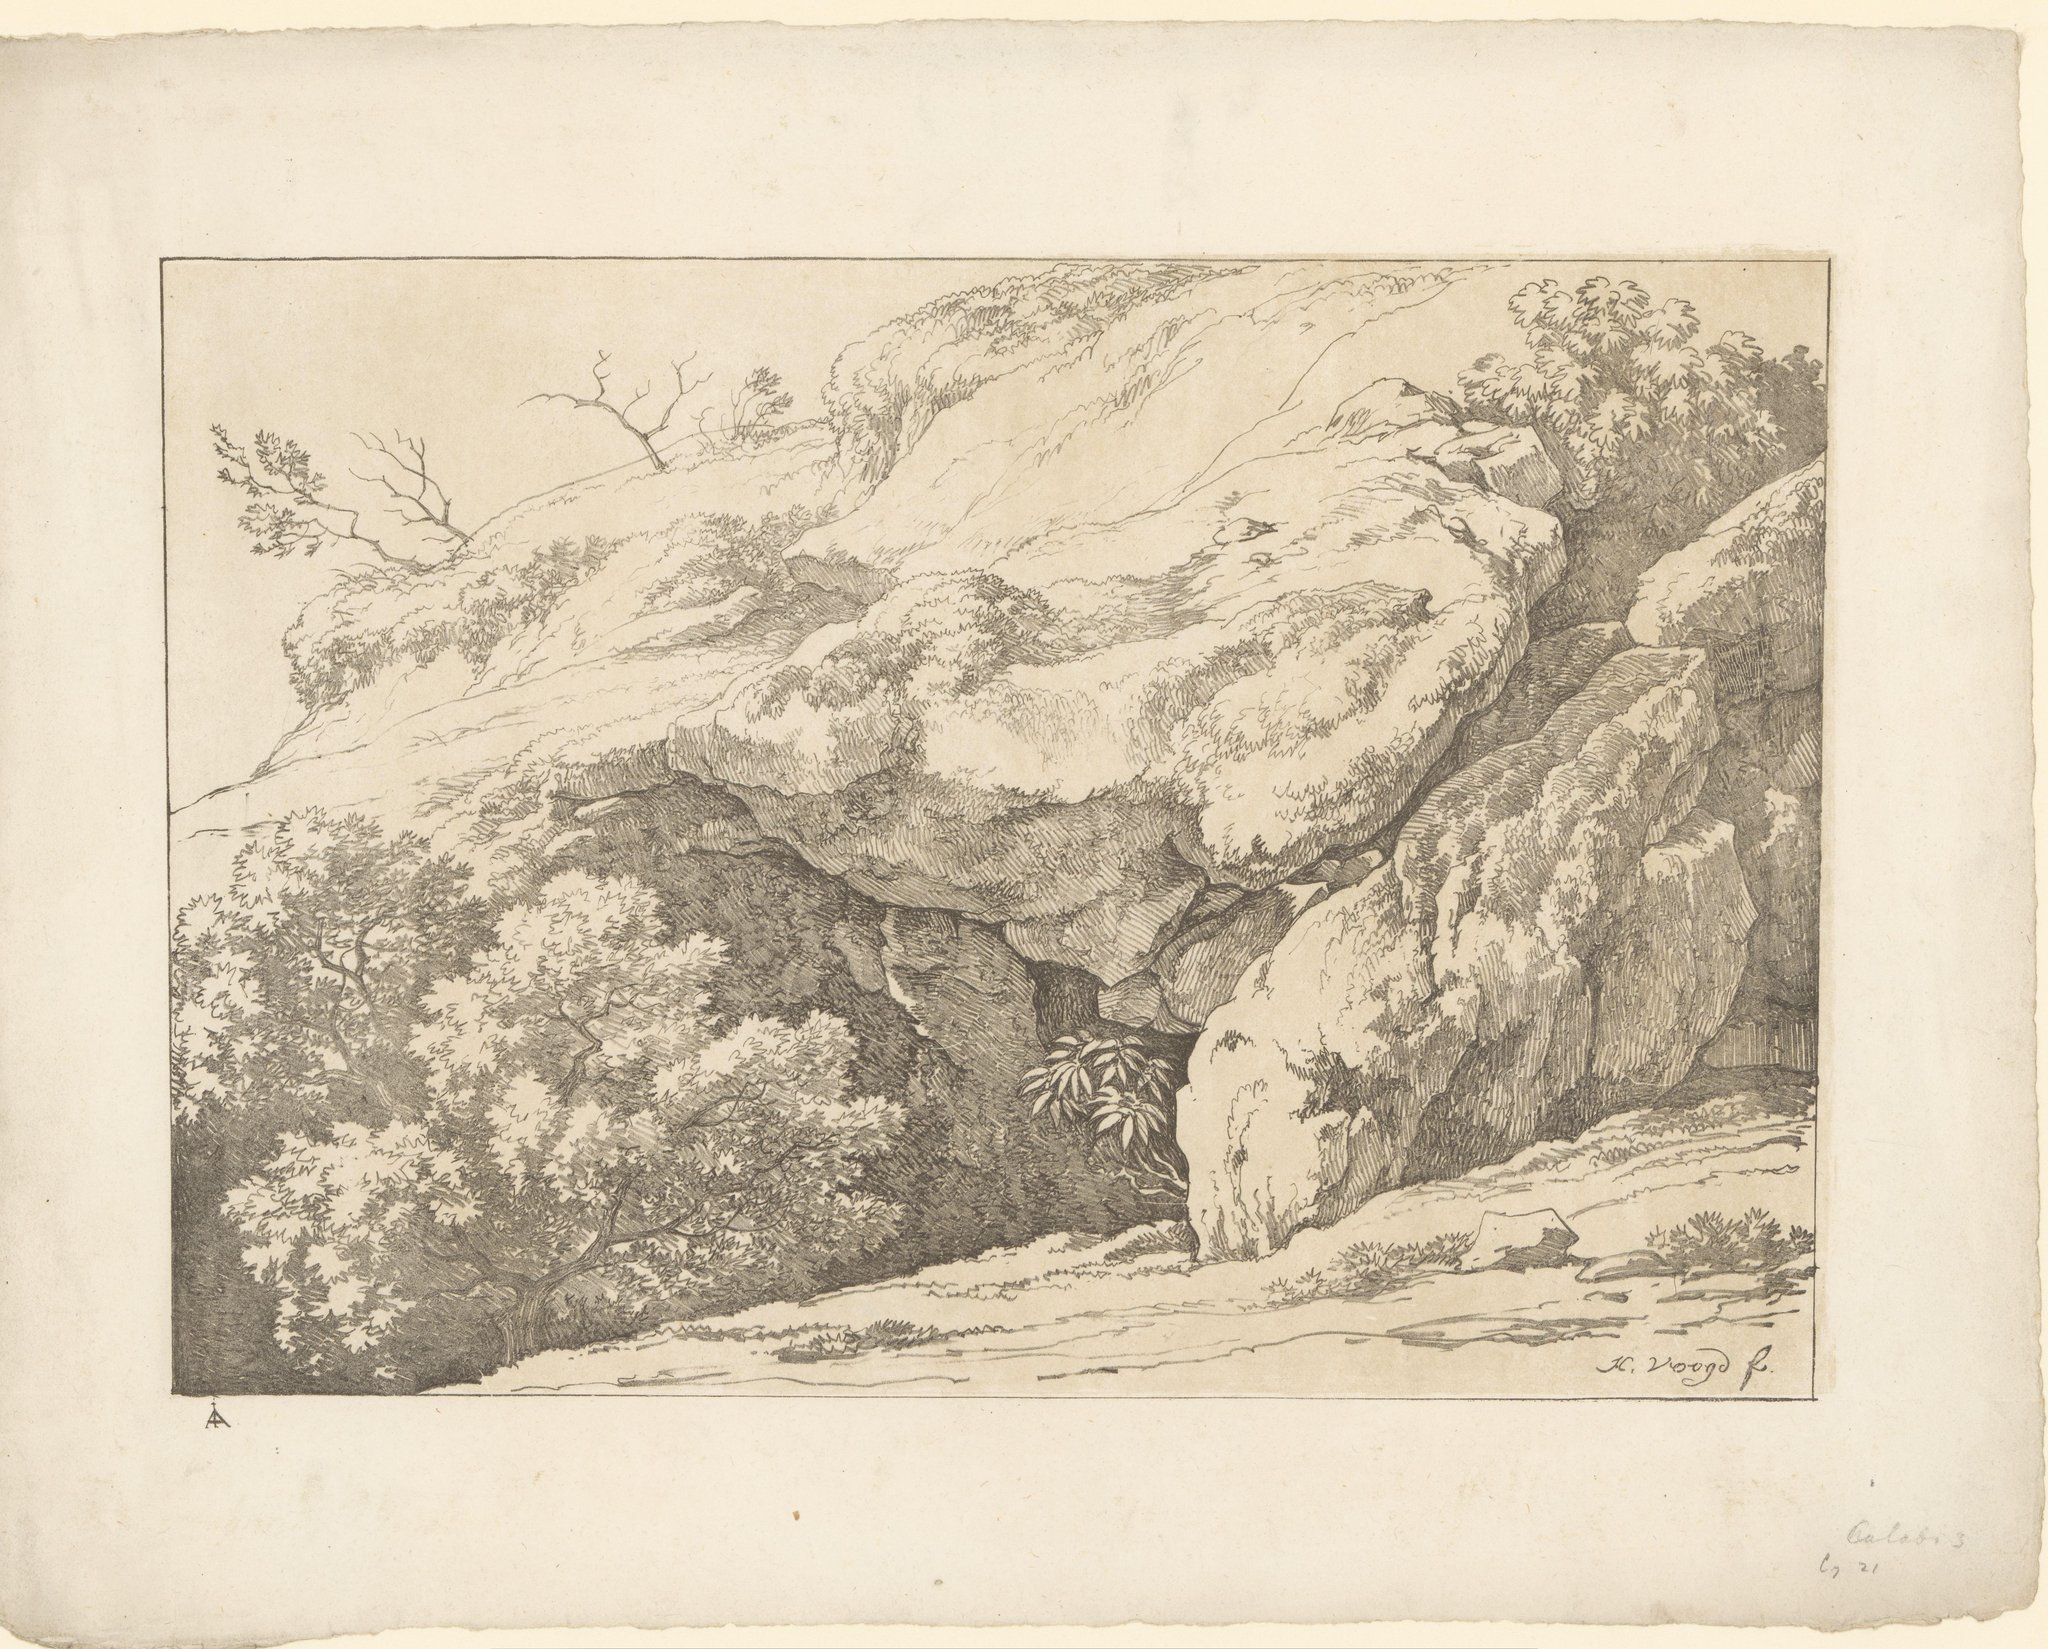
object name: print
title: Italiaanse landschappen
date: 1820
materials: paper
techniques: tone lithography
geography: rome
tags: landscapes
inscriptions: collector's mark: Lugt 2228, stamp: ‘School voor de grafische vakken te Utrecht’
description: Prent is onderdeel van een serie van twaalf.